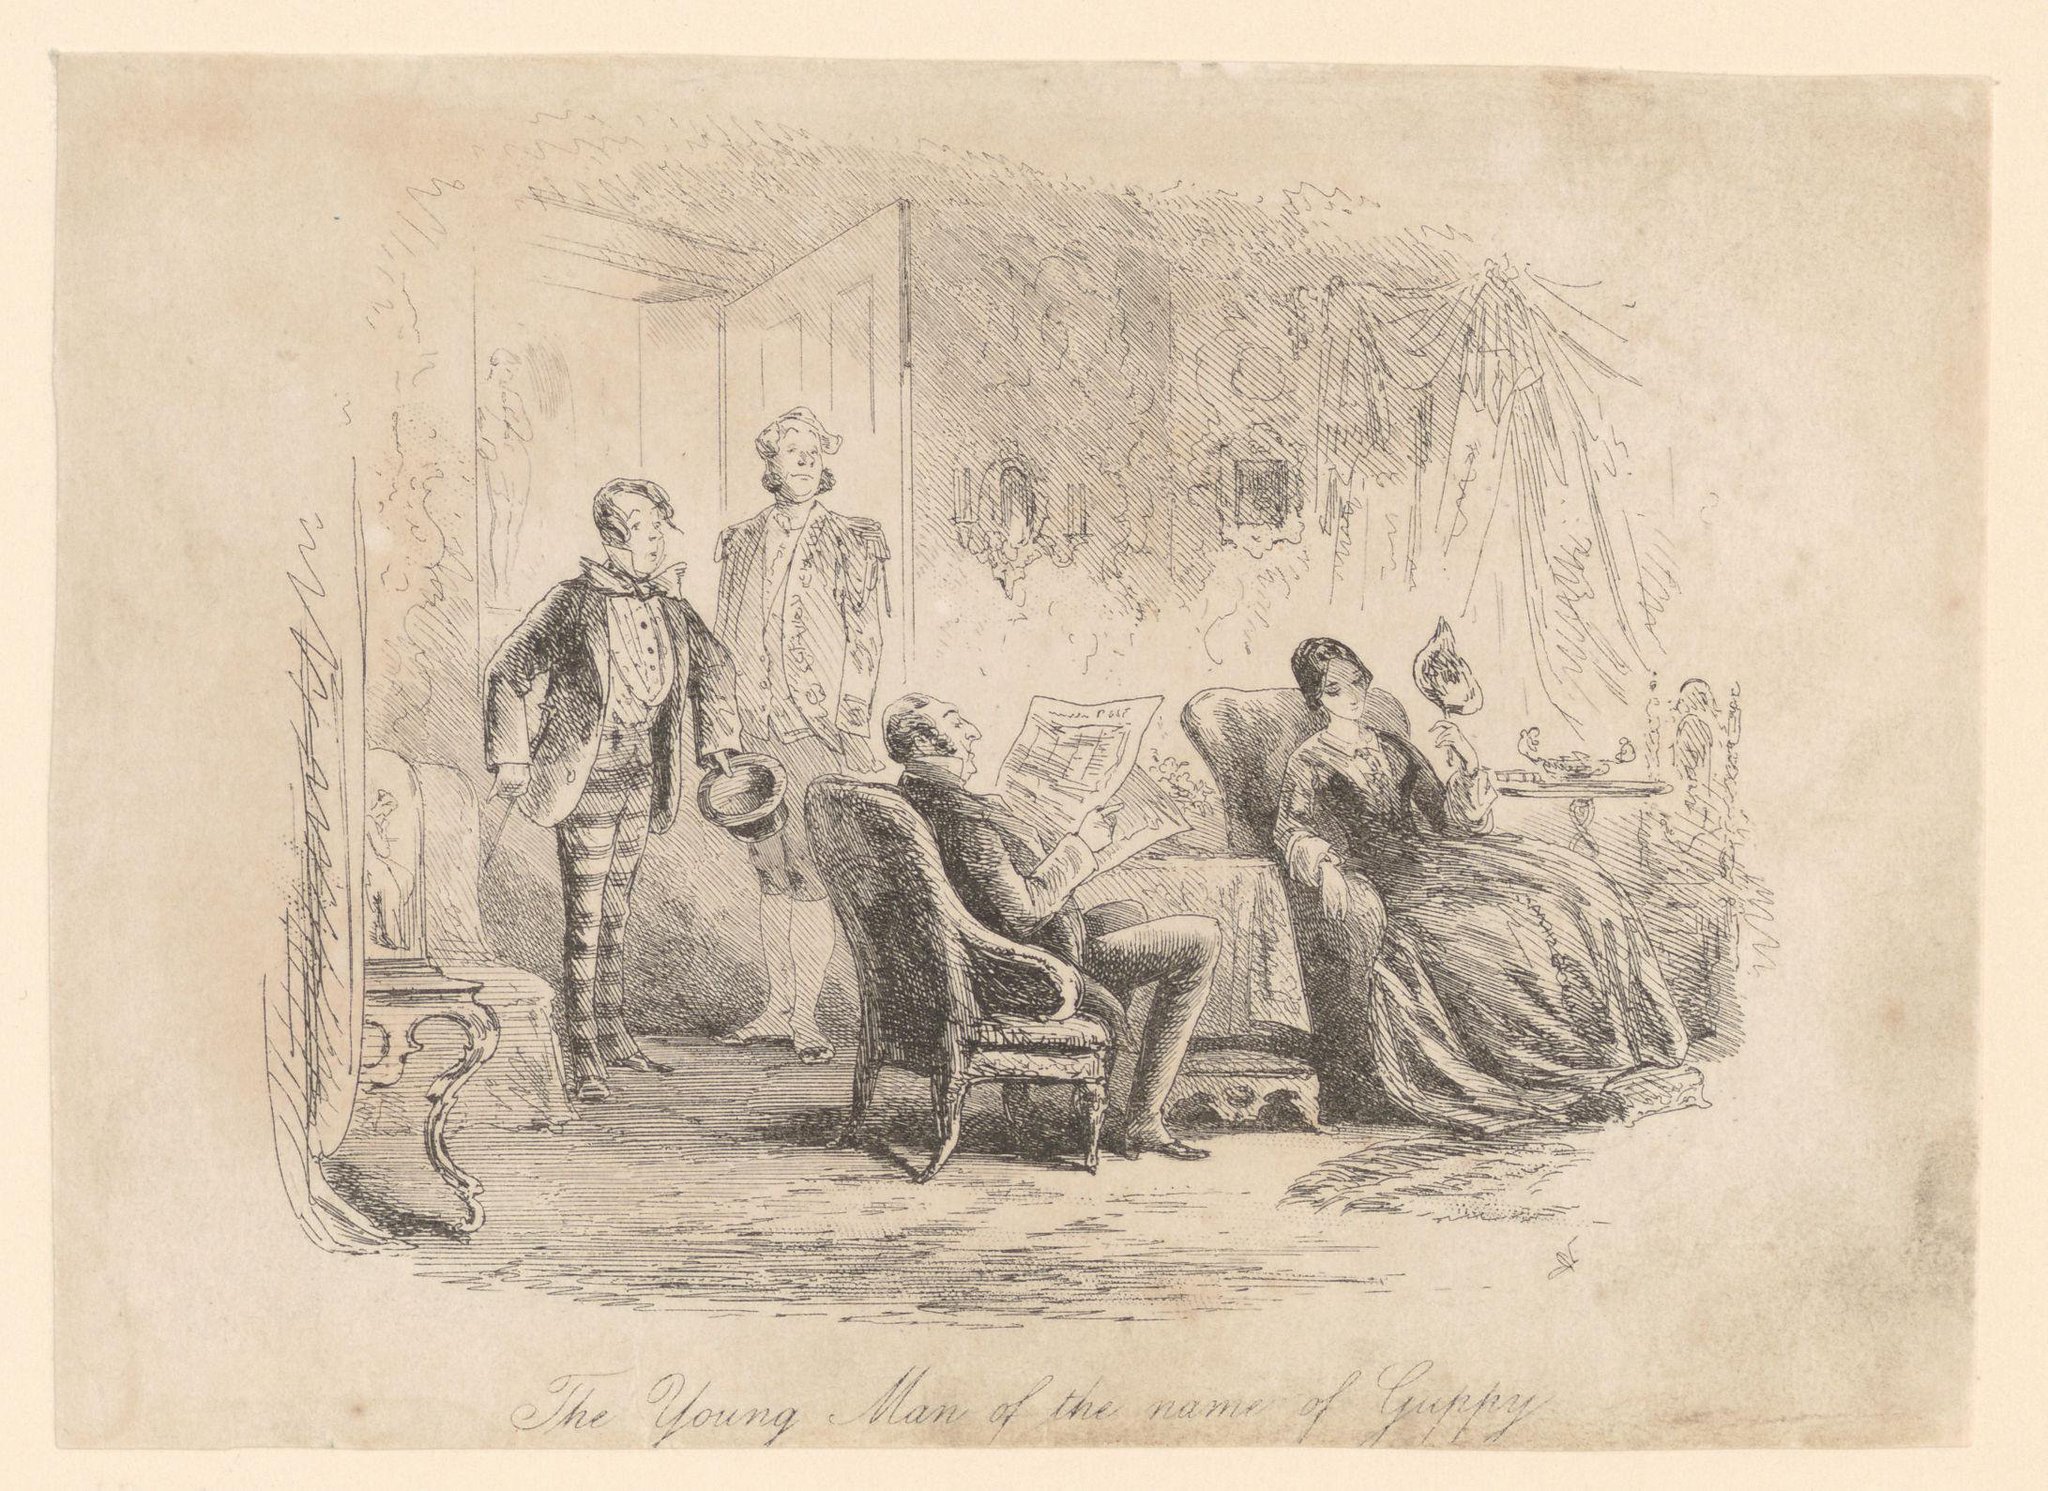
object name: book illustration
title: The Young Man of the name of Guppy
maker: hablot knight browne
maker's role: print maker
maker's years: 1815-1882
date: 1853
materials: paper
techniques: etching, roulette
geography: london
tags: reading, newspaper, news-sheet, living-room, parlour, sitting-room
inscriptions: collector's mark: Lugt 2228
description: Prent uit: Dickens, Charles. Bleak House. Londen: Bradbury & Evans, 1853, p. 283.